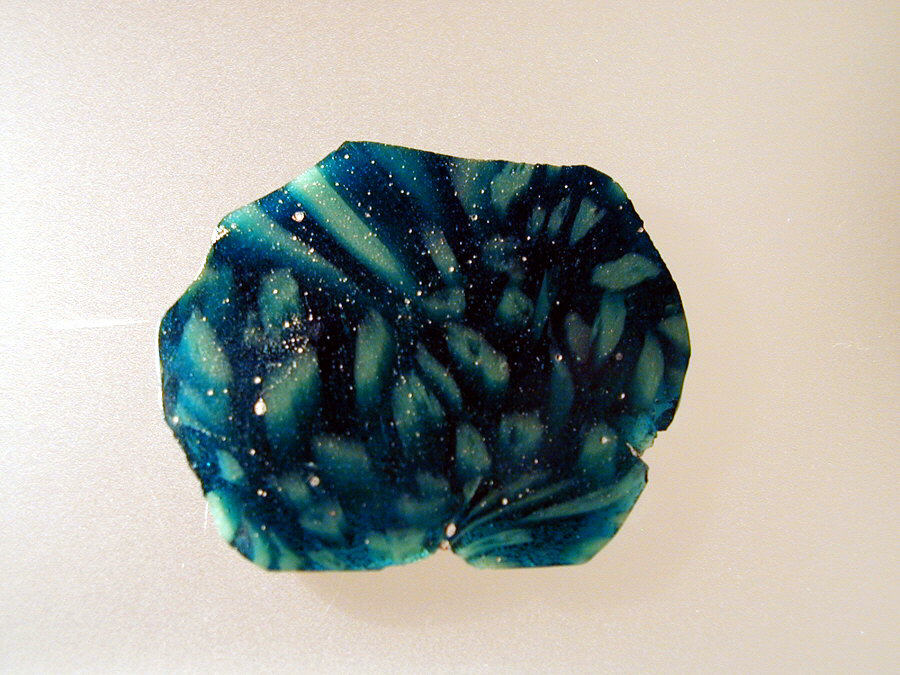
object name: fragment, mosaic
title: Glass mosaic inlay fragment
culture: roman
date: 34 BCE-33 CE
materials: glass